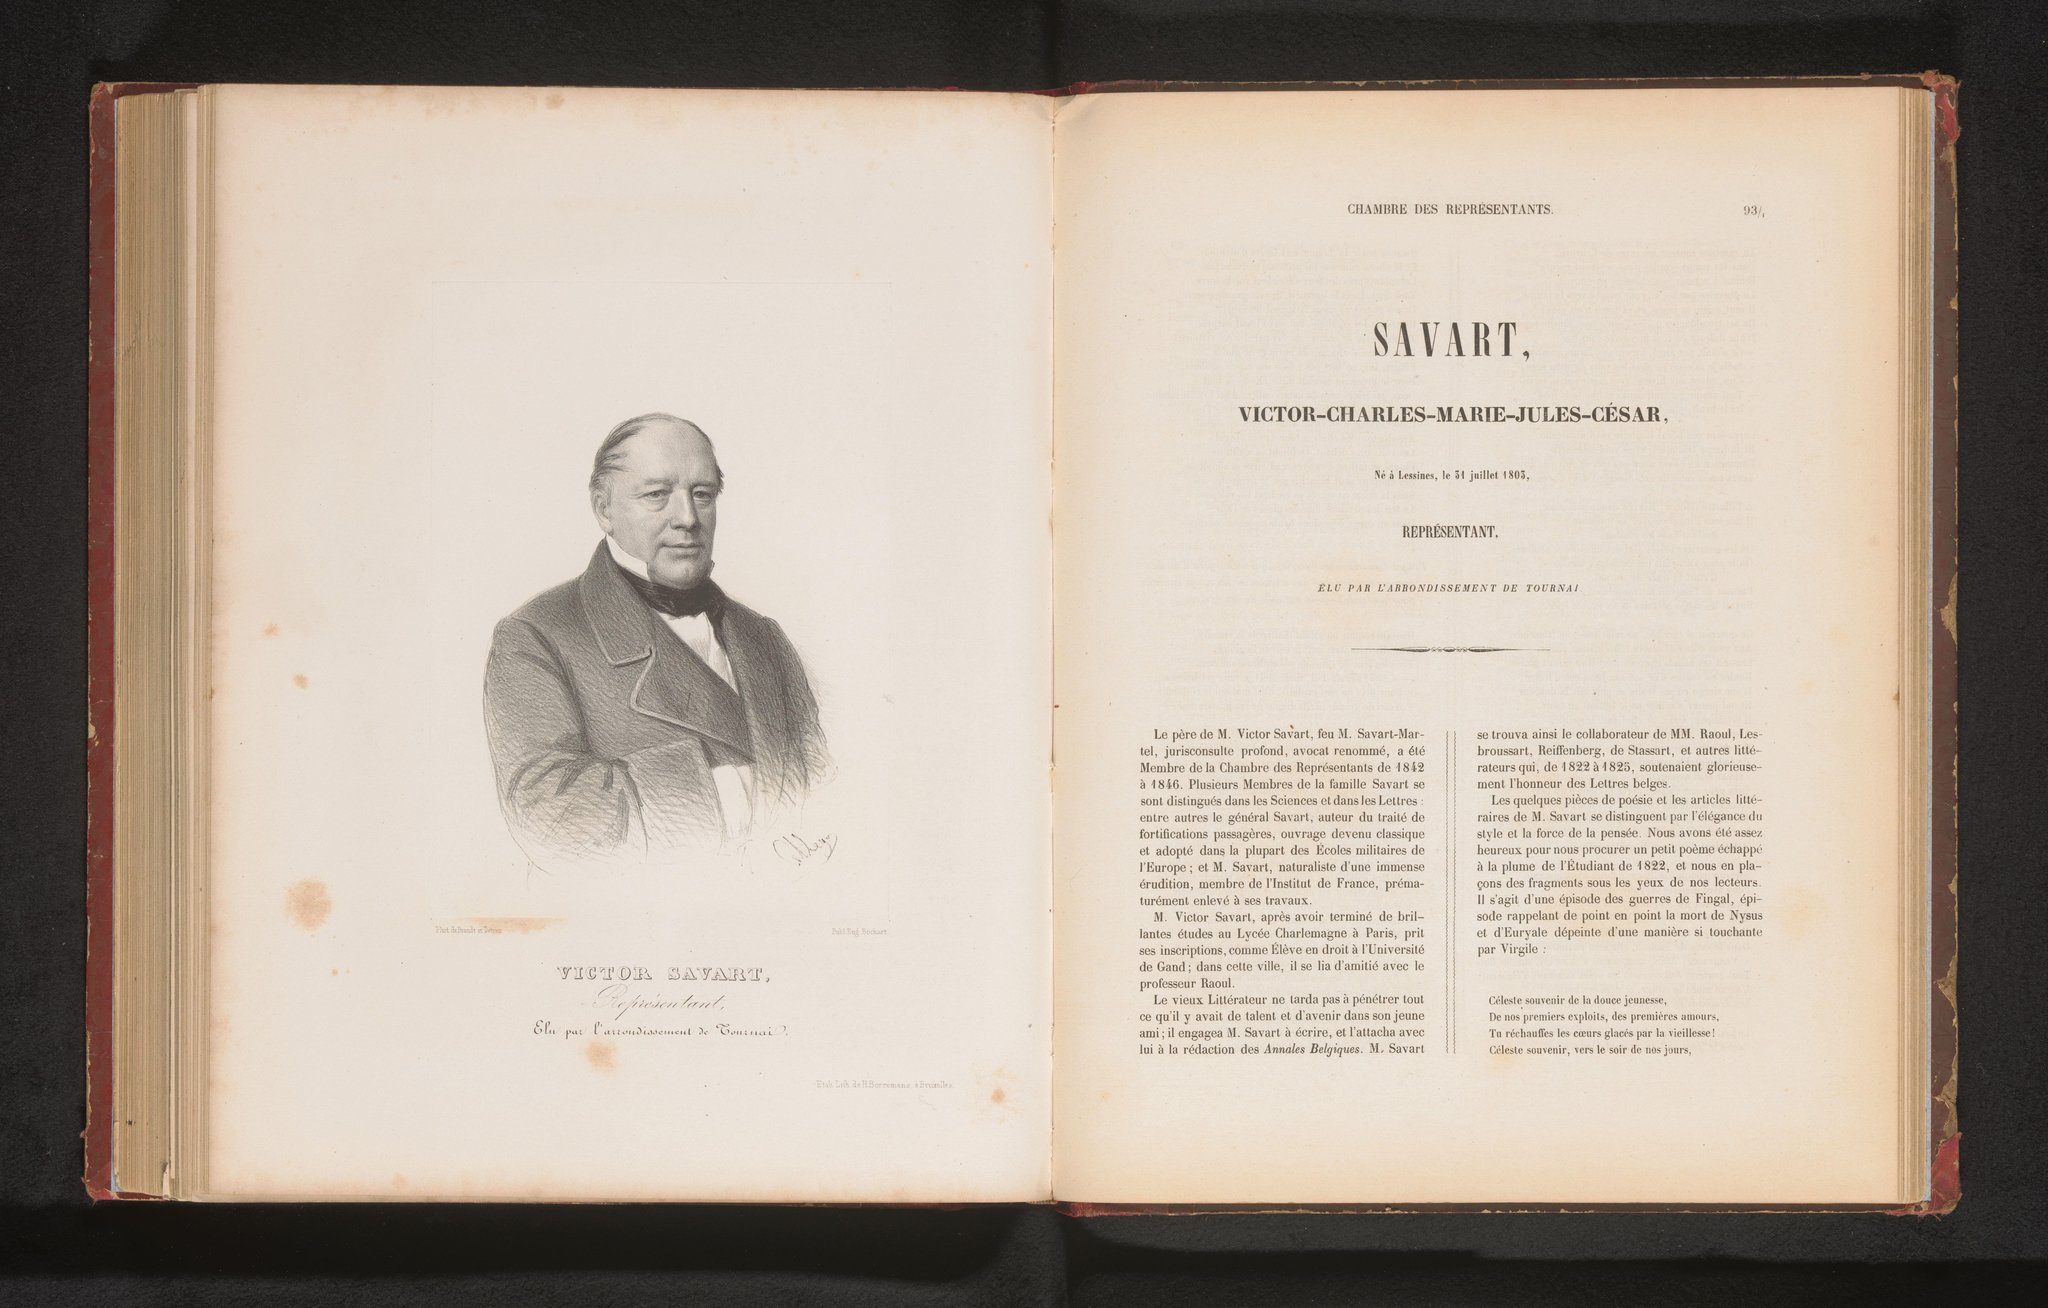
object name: reproduction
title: Reproductie van een foto van een portret van Victor Savart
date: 1853-1858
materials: paper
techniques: lithograph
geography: brussels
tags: politician, historical persons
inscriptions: inscription: ‘Représentant,/ Elu par l'arrondissement de Tournai.’